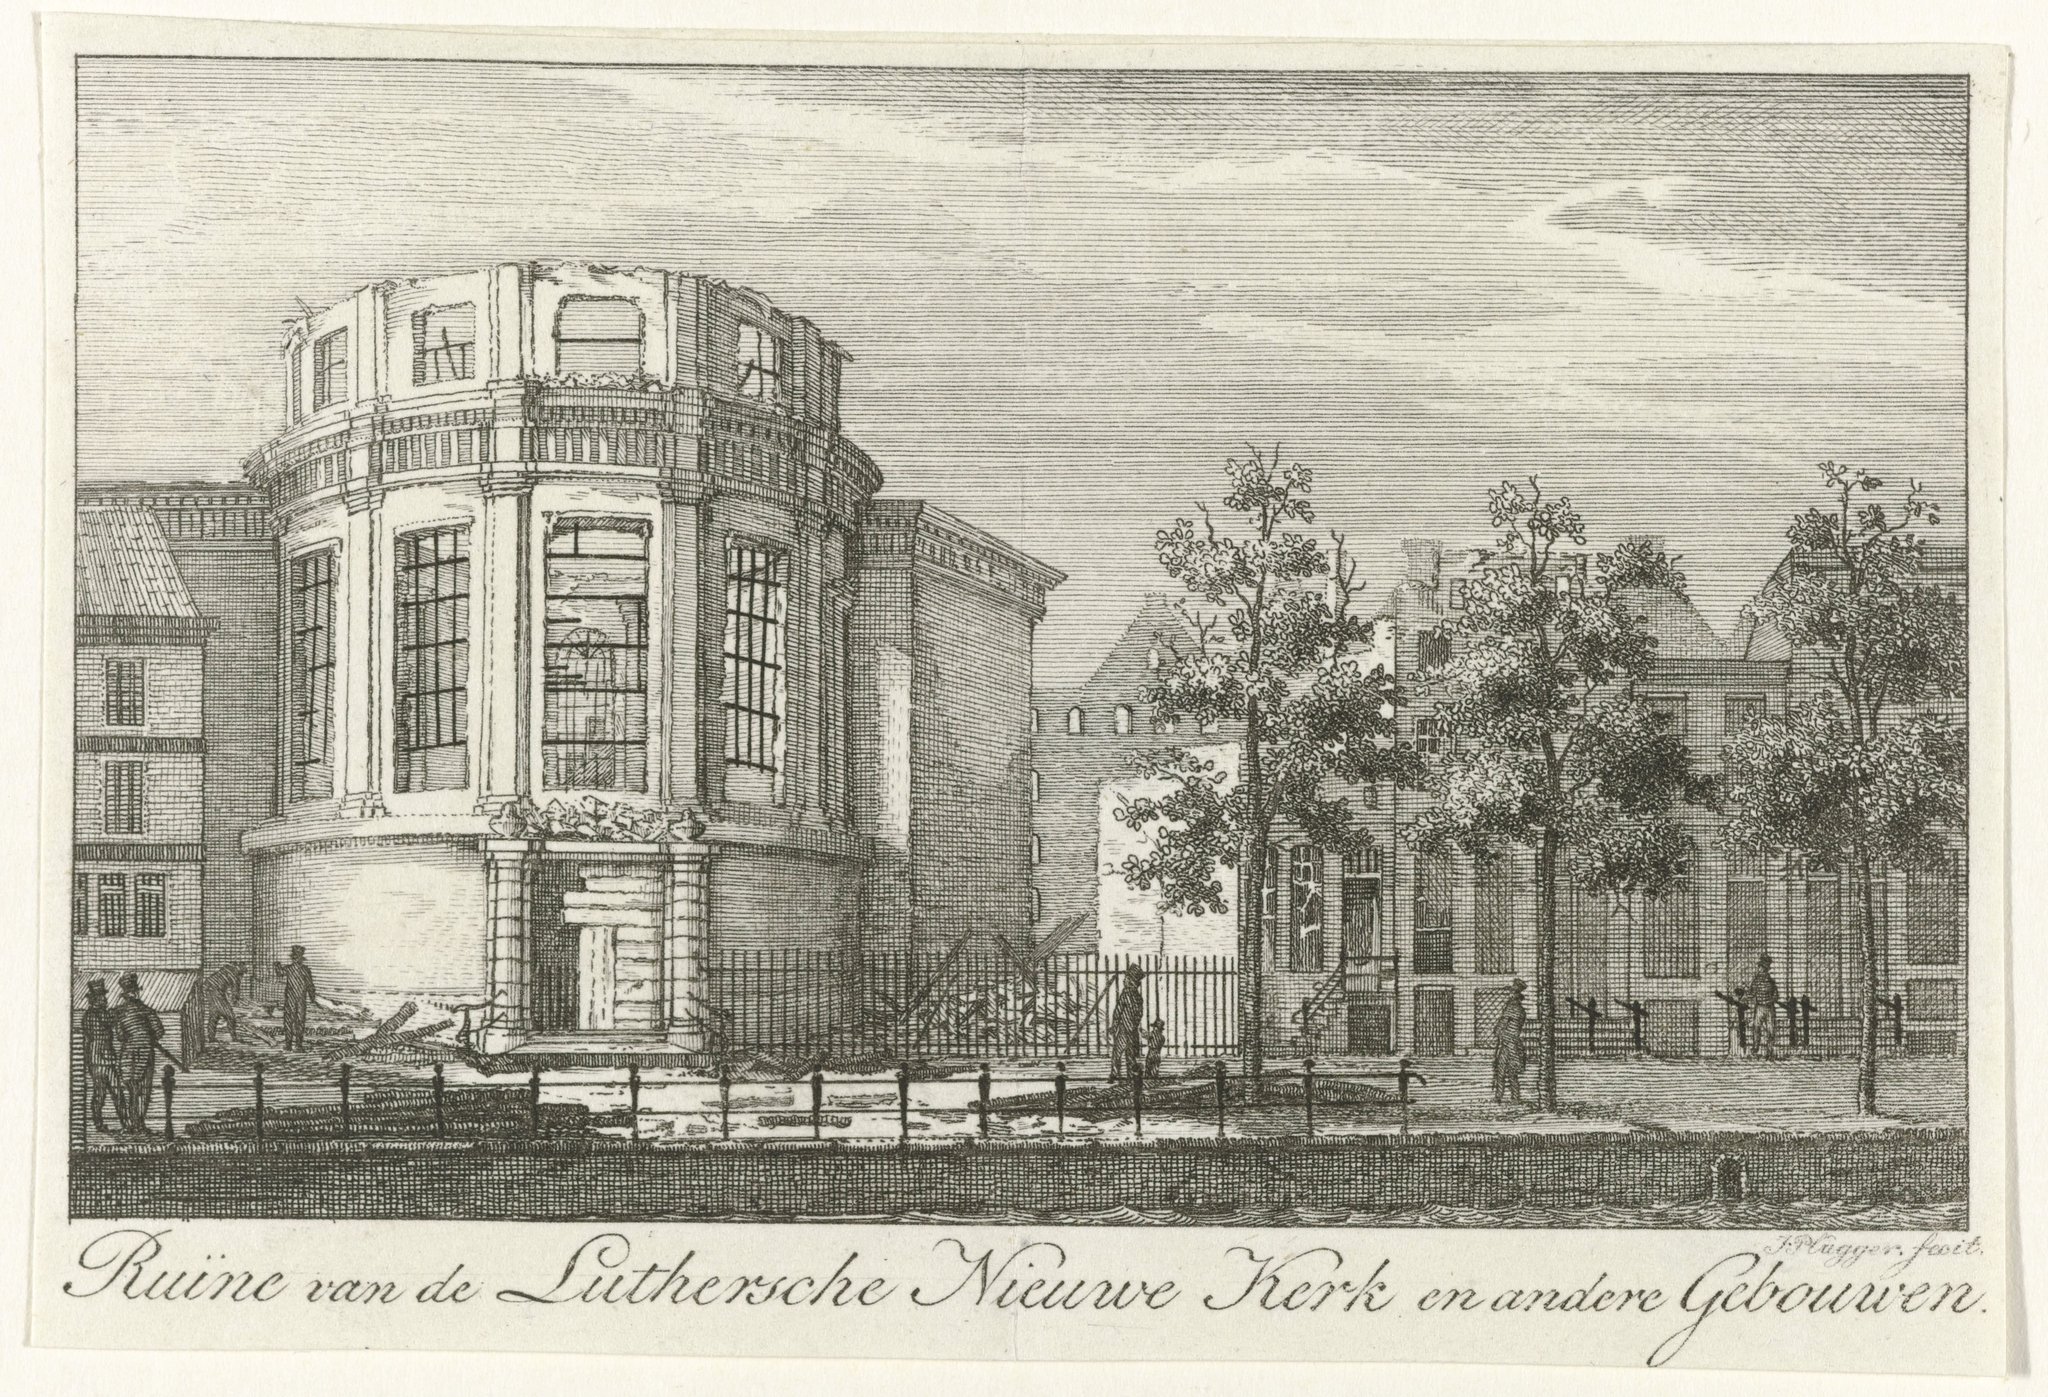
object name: print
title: Ruïne van de Luthersche Nieuwe Kerk en andere Gebouwen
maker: jacob plügger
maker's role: print maker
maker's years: 1795-1871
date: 1822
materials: paper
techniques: etching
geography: netherlands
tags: church (exterior), ruin of church, monastery, etc.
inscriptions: collector's mark: Lugt 2228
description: Gezicht op de ruïne van de Koepelkerk of Nieuwe Lutherse Kerk aan het Singel te Amsterdam, na de brand van 18 september 1822. Zie pendant.